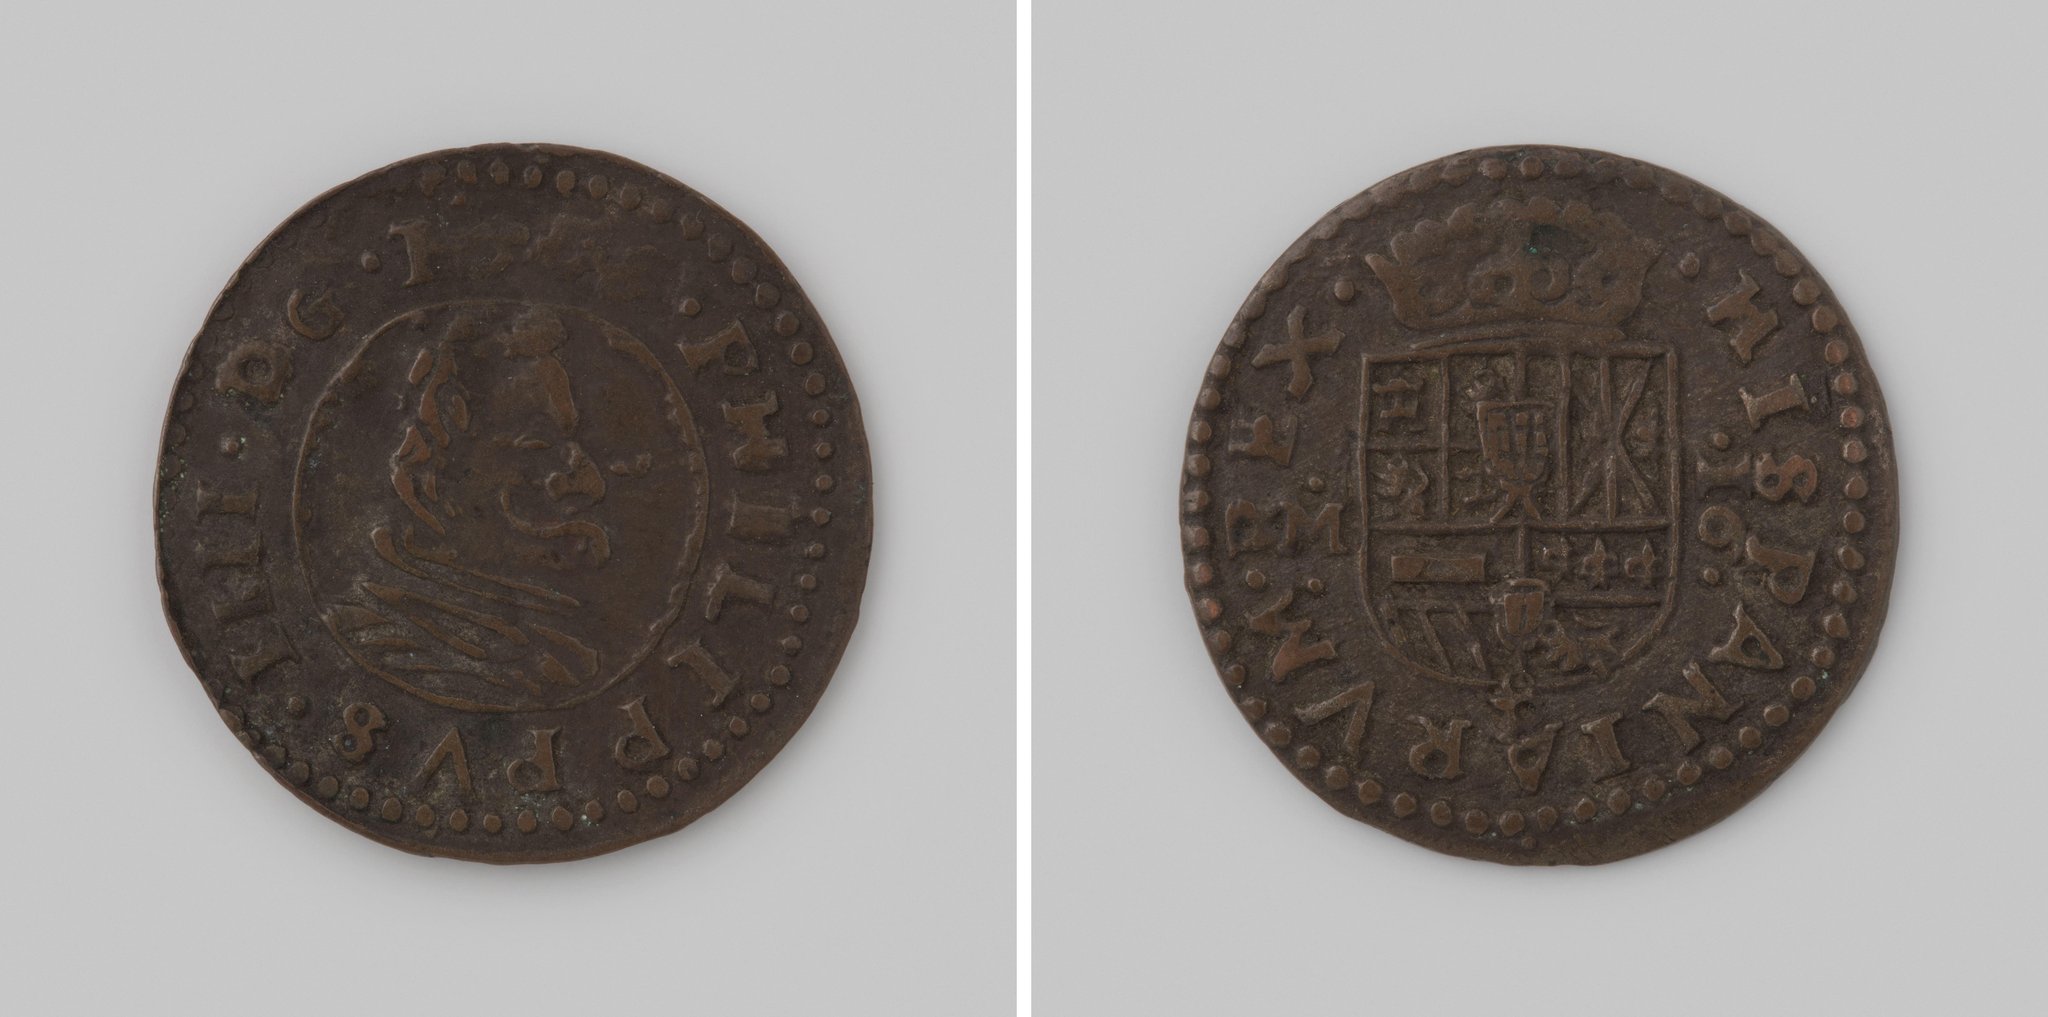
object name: coin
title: Spanje, koning Philips III, 16 maravedis,1663 M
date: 1663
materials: copper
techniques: striking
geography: madrid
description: Koperen munt. Voorzijde: borstbeeld van de koning naar rechts. Jaartal bovenaan in omschrift. Keerzijde: gekroond samengesteld wapenschild. Rechts daavan waarde-aanduiding: 16, links daarvan letter M [=Madrid].